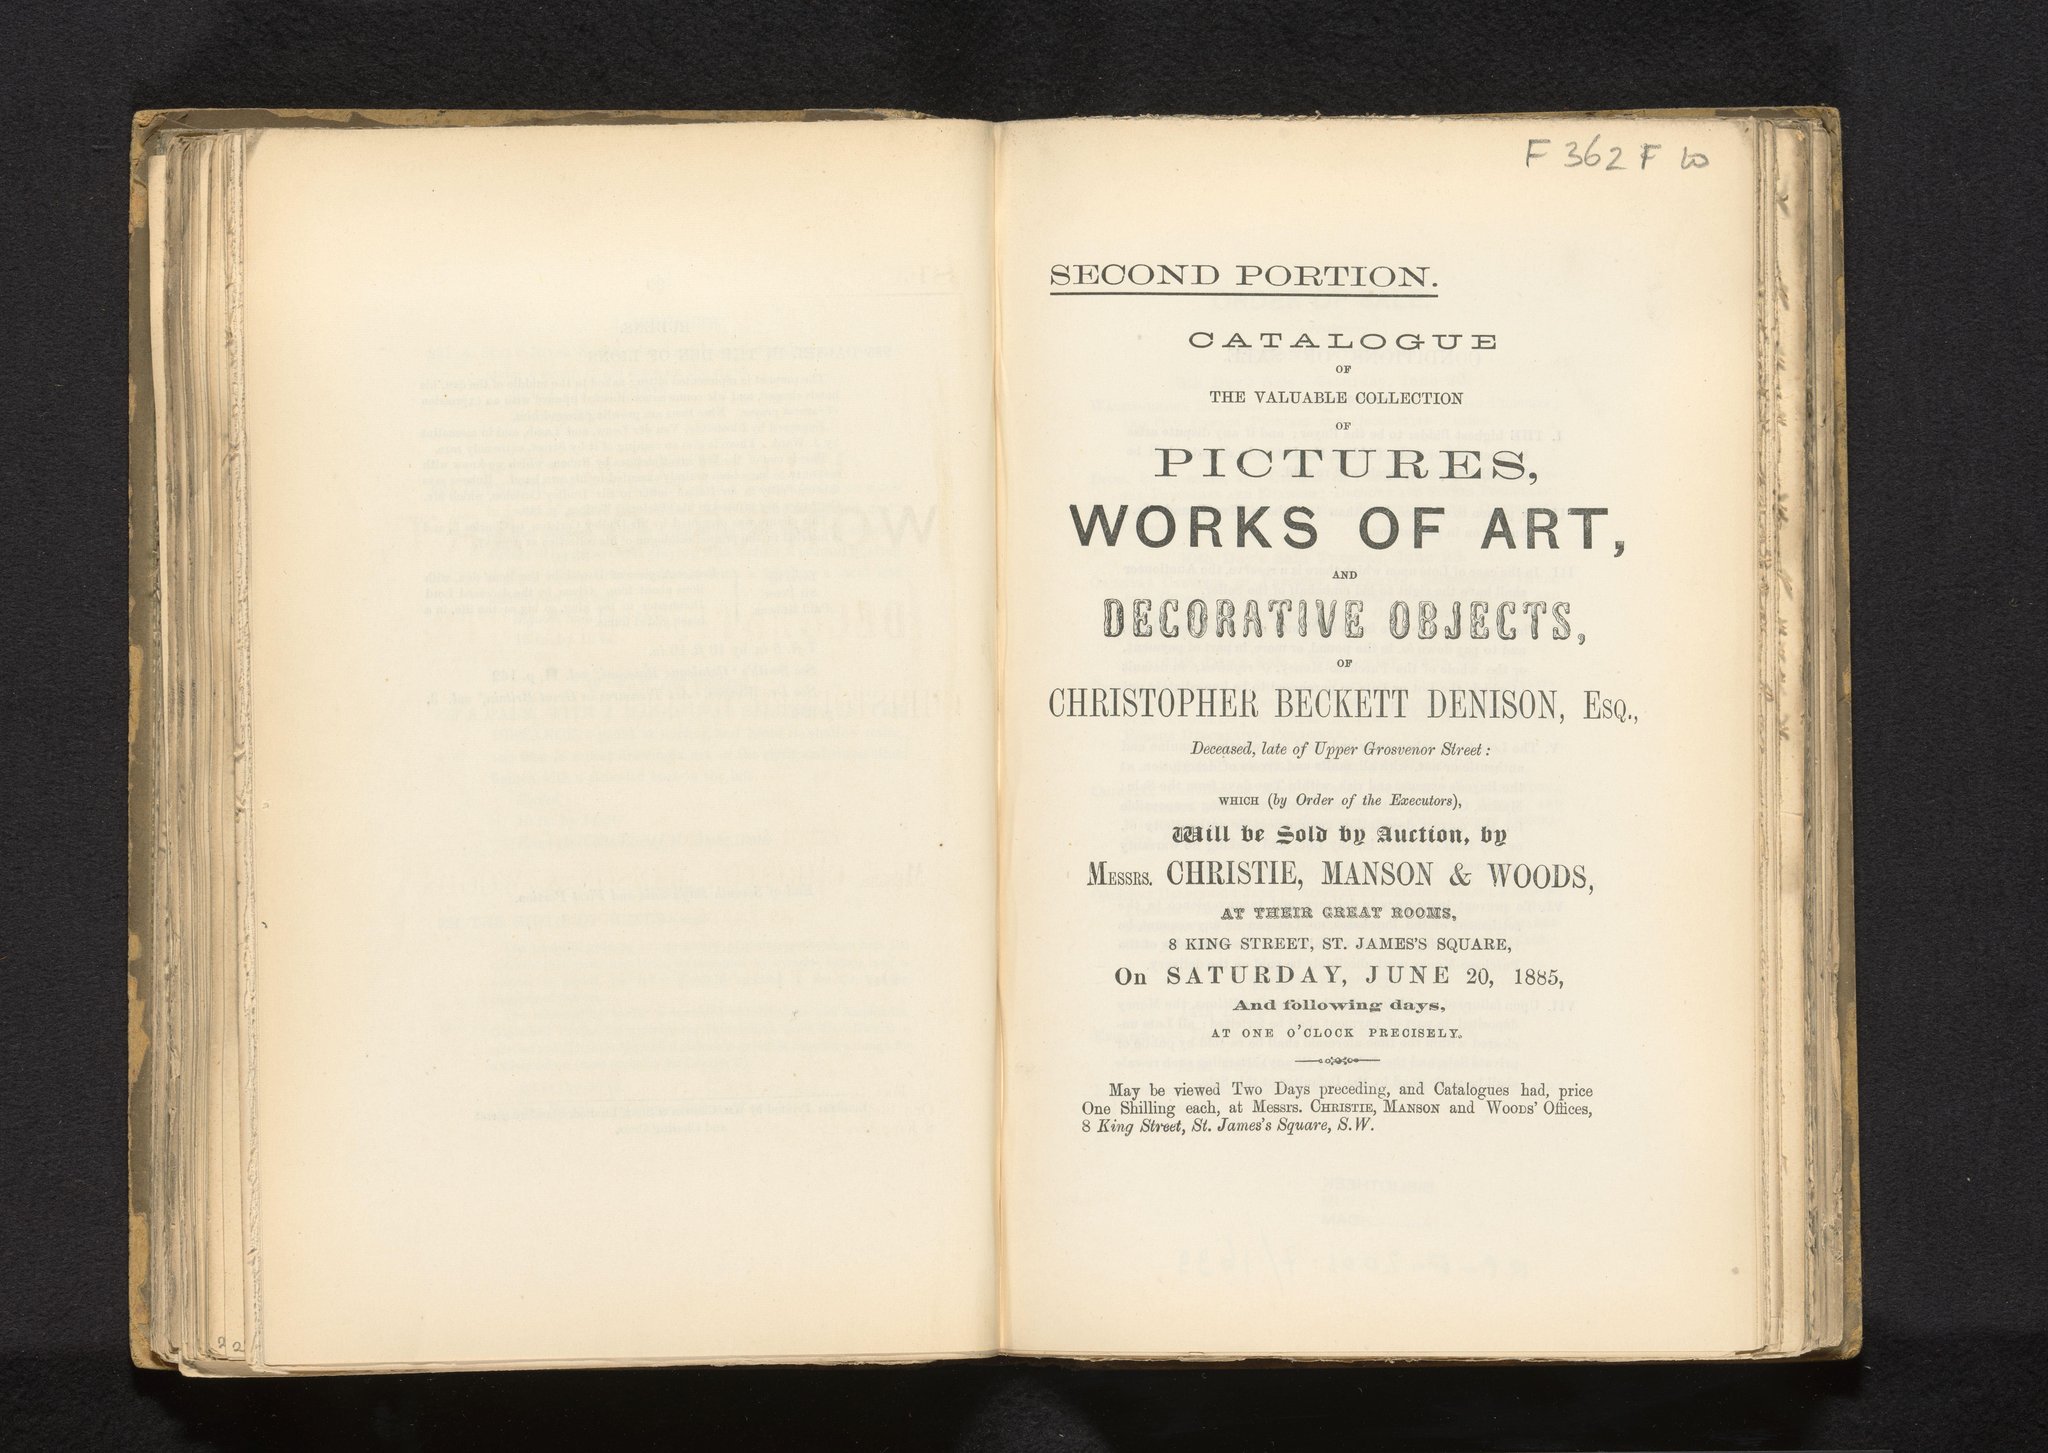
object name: book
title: Catalogue of the valuable collection of pictures, works of art, and decorative objects, of Christopher Beckett Denison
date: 1885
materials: cardboard, paper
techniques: decorated paper, printing, woodburytype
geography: london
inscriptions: date: ‘OCT/ 1998’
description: Dit boek zit samen in een band met RP-F-2001-7-1698 en RP-F-2001-7-1700.